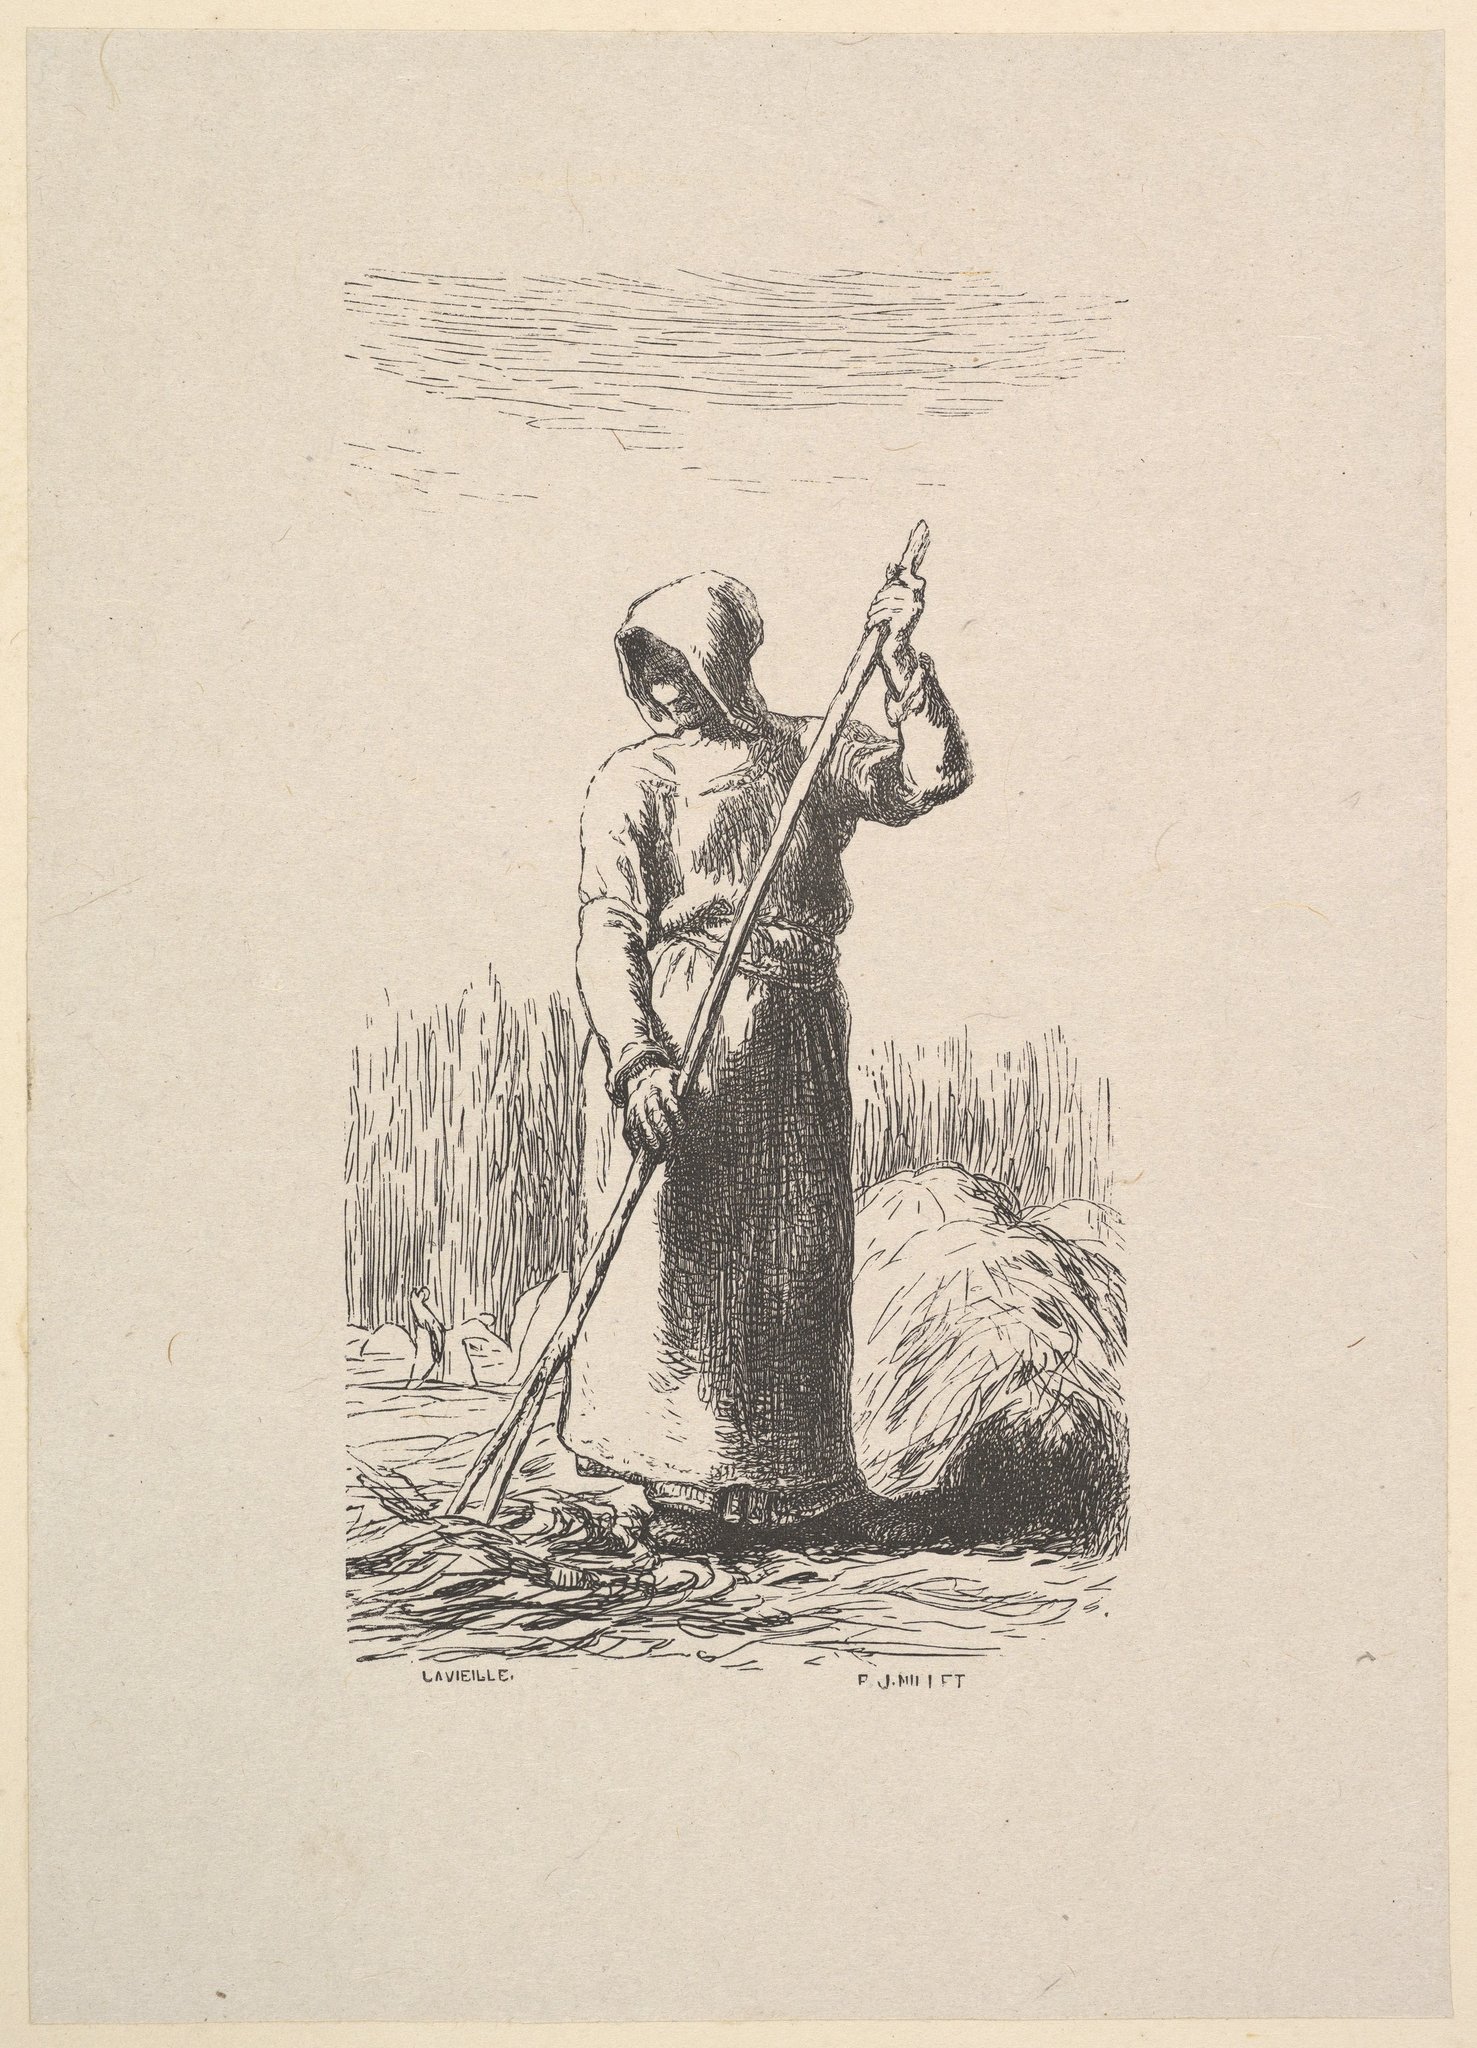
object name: print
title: The Raker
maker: jean-françois millet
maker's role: artist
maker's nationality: french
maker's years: 1814-1875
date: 1853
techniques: printmaking, woodcut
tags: women,working